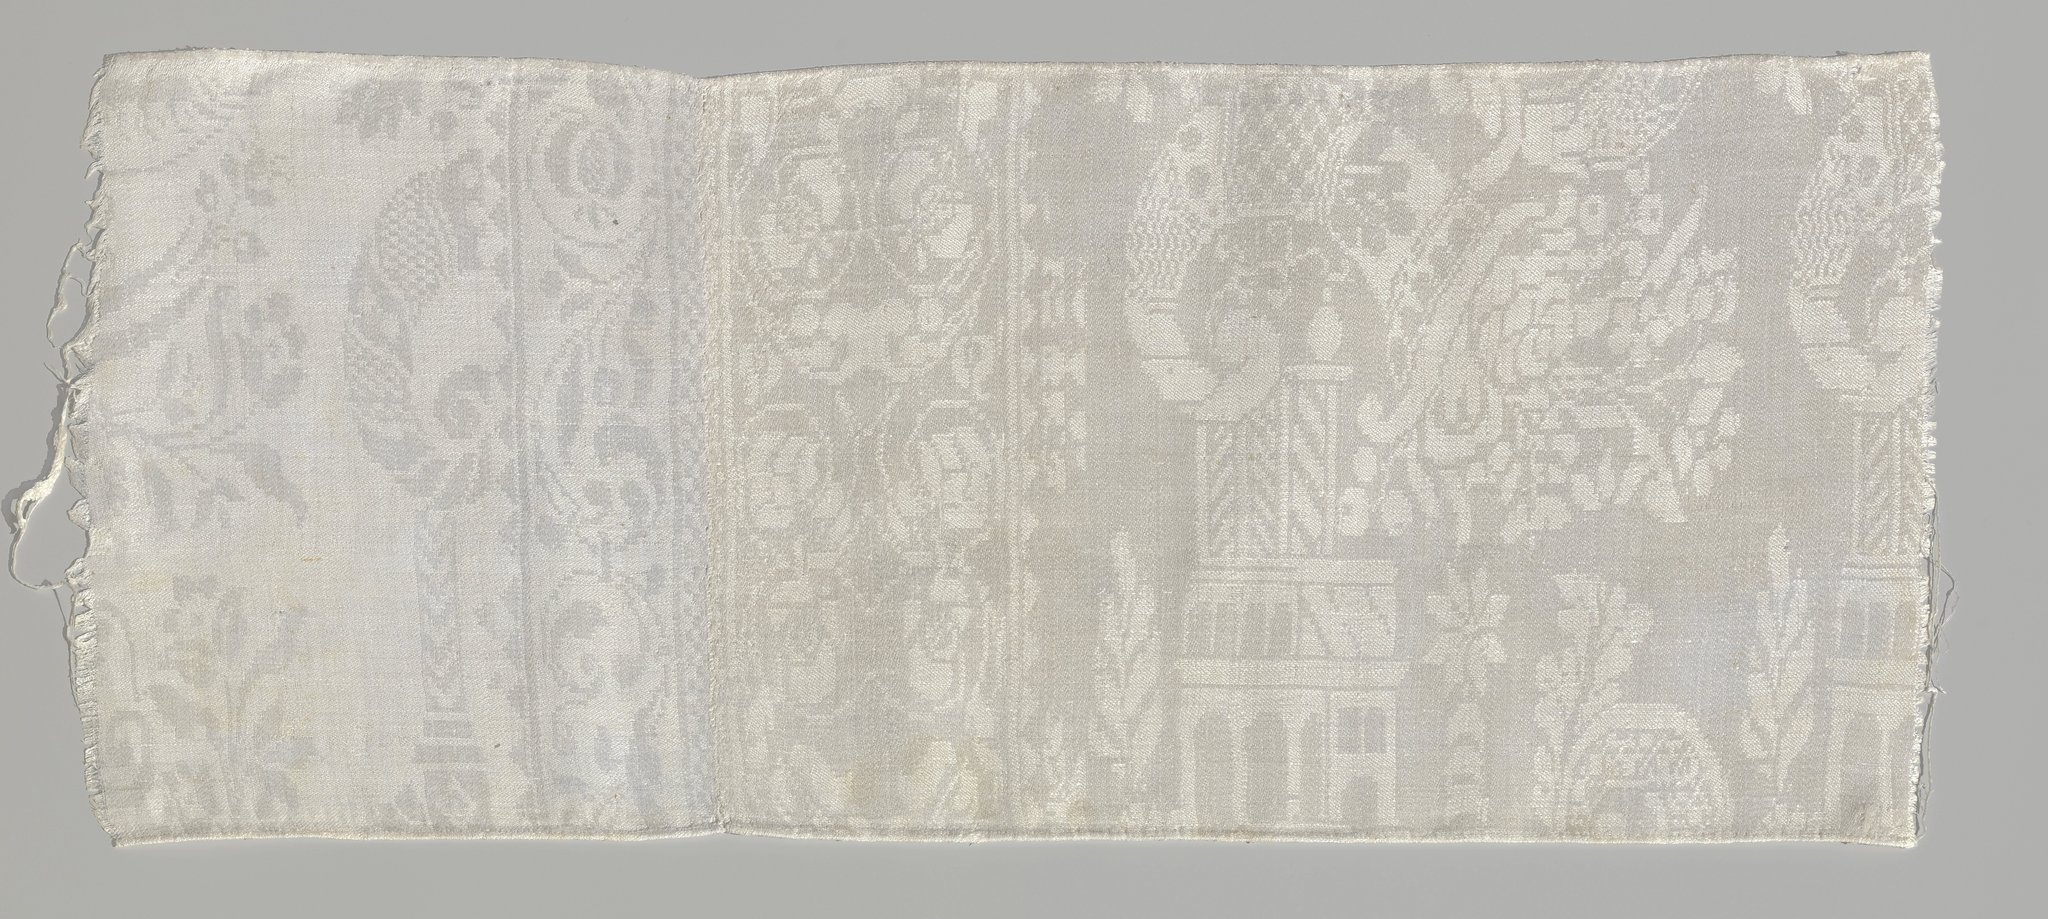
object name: tablecloth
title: Fragment van een tafellaken met een hoorn des overvloeds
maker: Anonymous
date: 1708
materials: linen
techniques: damask, weave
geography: germany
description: Fragment van een tafellaken van linnendamast met een hoorn des overvloeds. Recht naast elkaar herhaalde asymmetrische motieven van het bovenstuk van een toren en naar rechts openende, sterk gekromde, geblokte en geschaakte hoorn, waaruit bloemen tevoorschijn komen. Brede rand van symmetrisch verdubbelde spiraalranken met granaatappel en andere bloem.